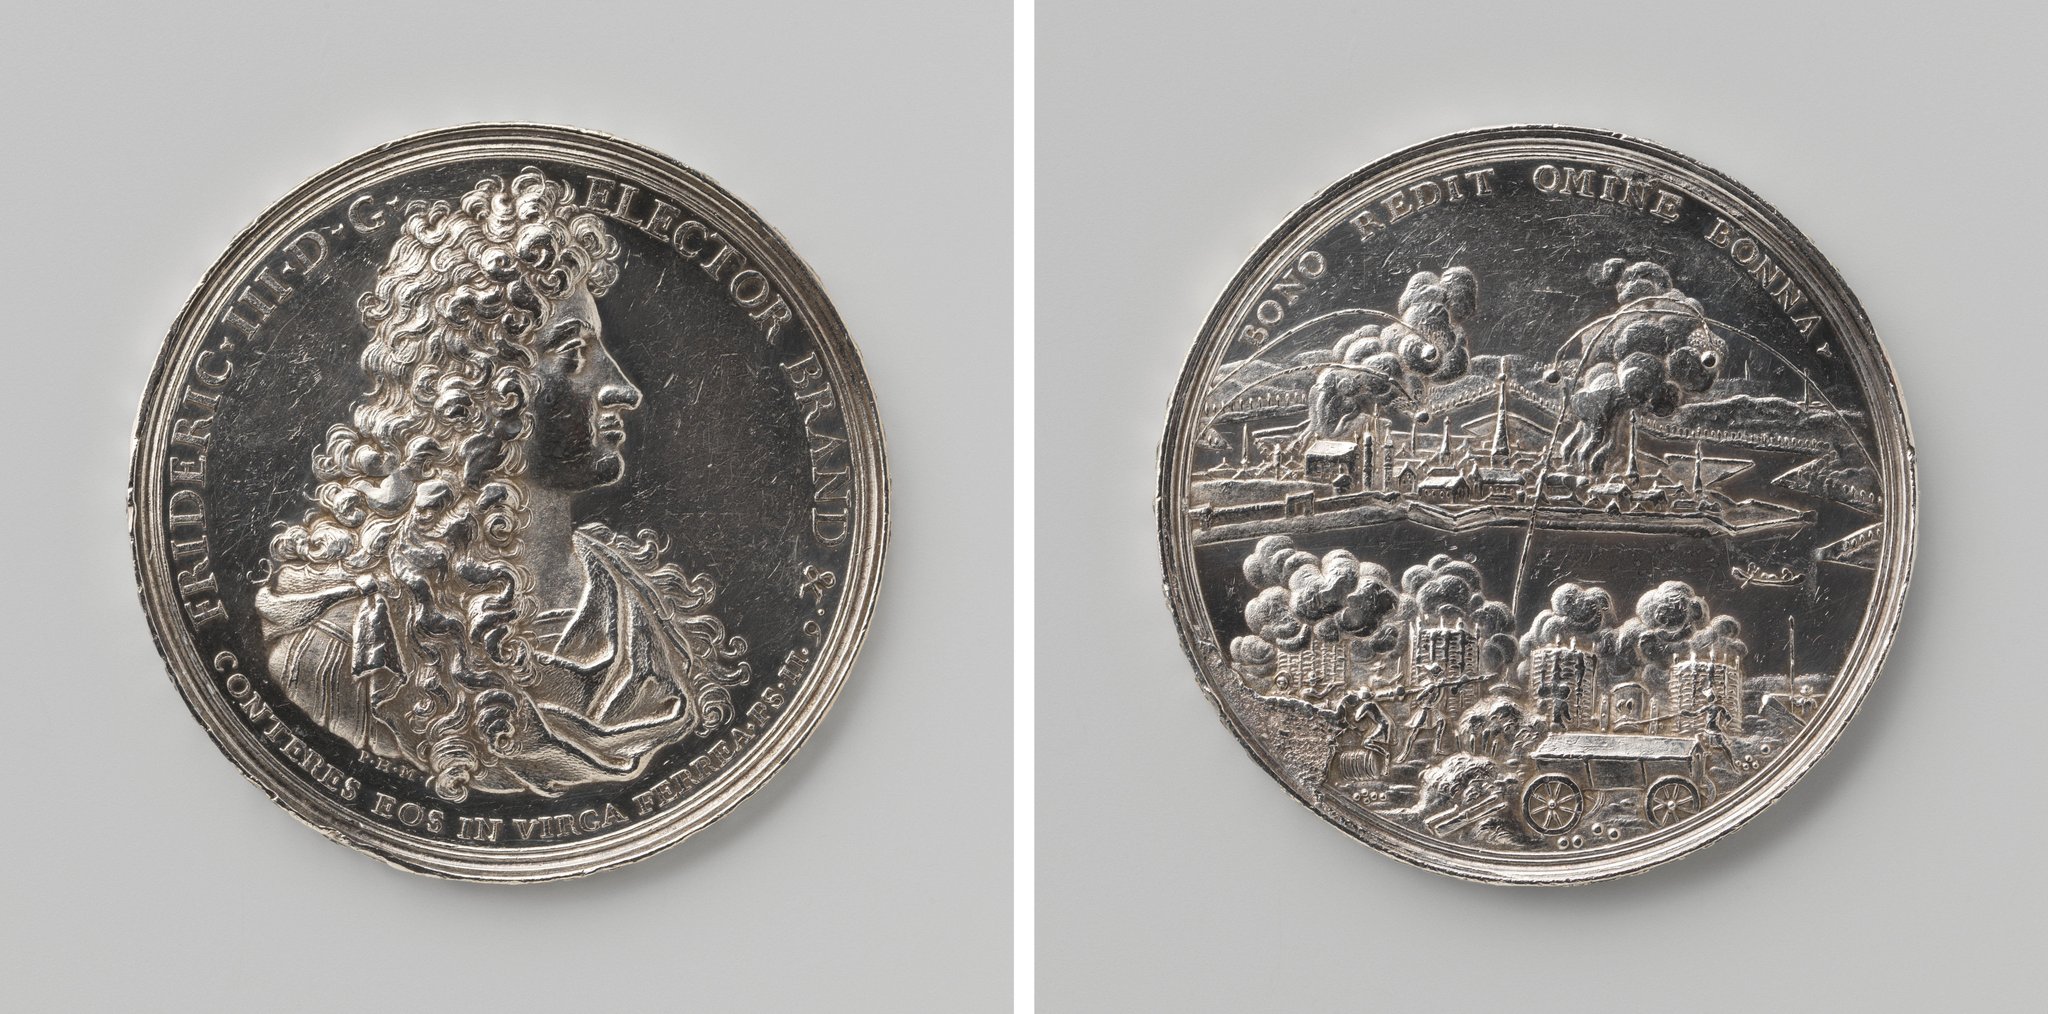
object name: history medal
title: Inname van Bonn, ter ere van Frederik III, keurvorst van Brandenburg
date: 1689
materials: silver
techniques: striking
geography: nuremberg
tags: berlin, frederik i koning van pruisen